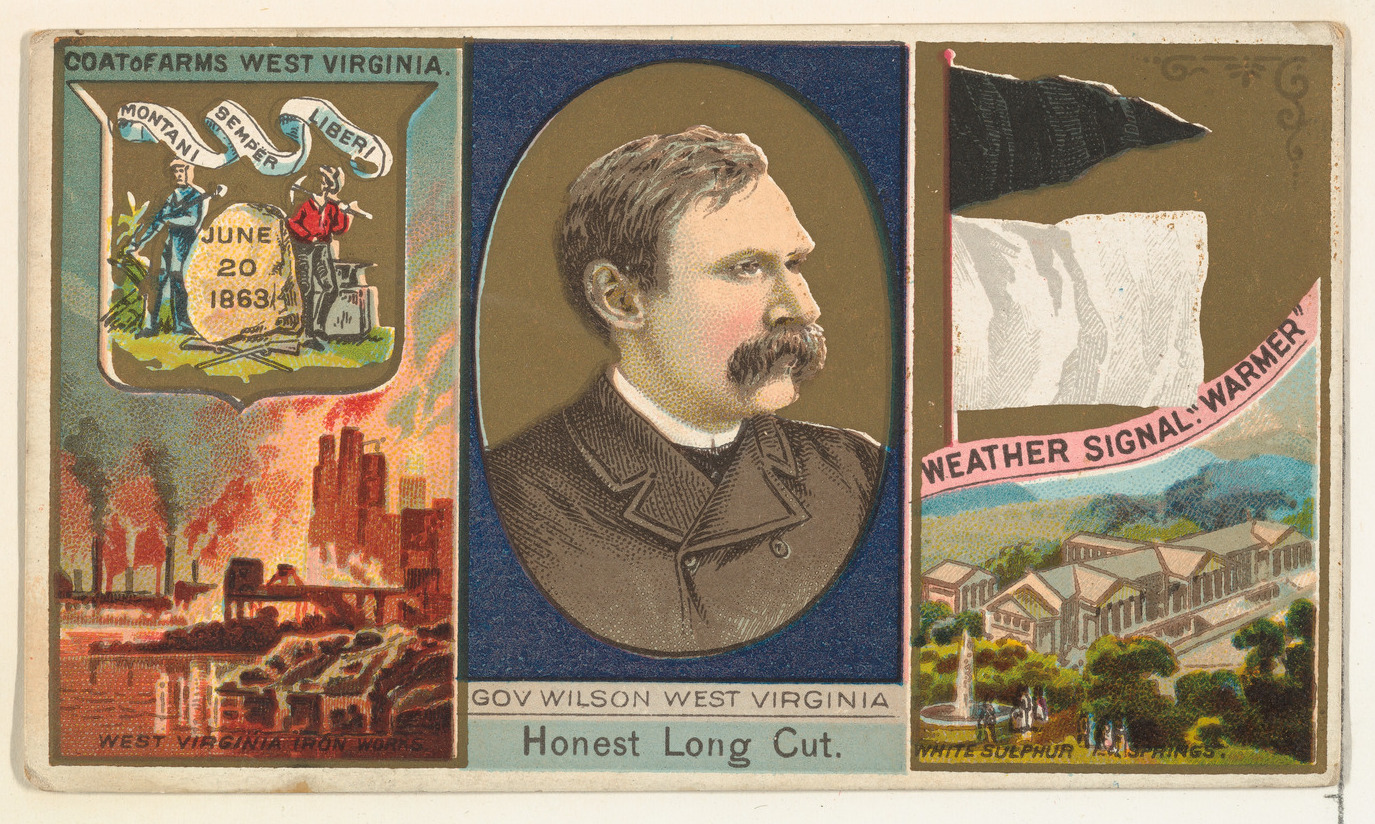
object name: print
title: Governor Wilson, West Virginia, from "Governors, Arms, Etc." series (N133-1), issued by Duke Sons & Co.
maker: w. duke, sons & co.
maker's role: publisher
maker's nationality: american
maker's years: 1870-1920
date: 1888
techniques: color lithograph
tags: men,profiles,coat of arms,flags